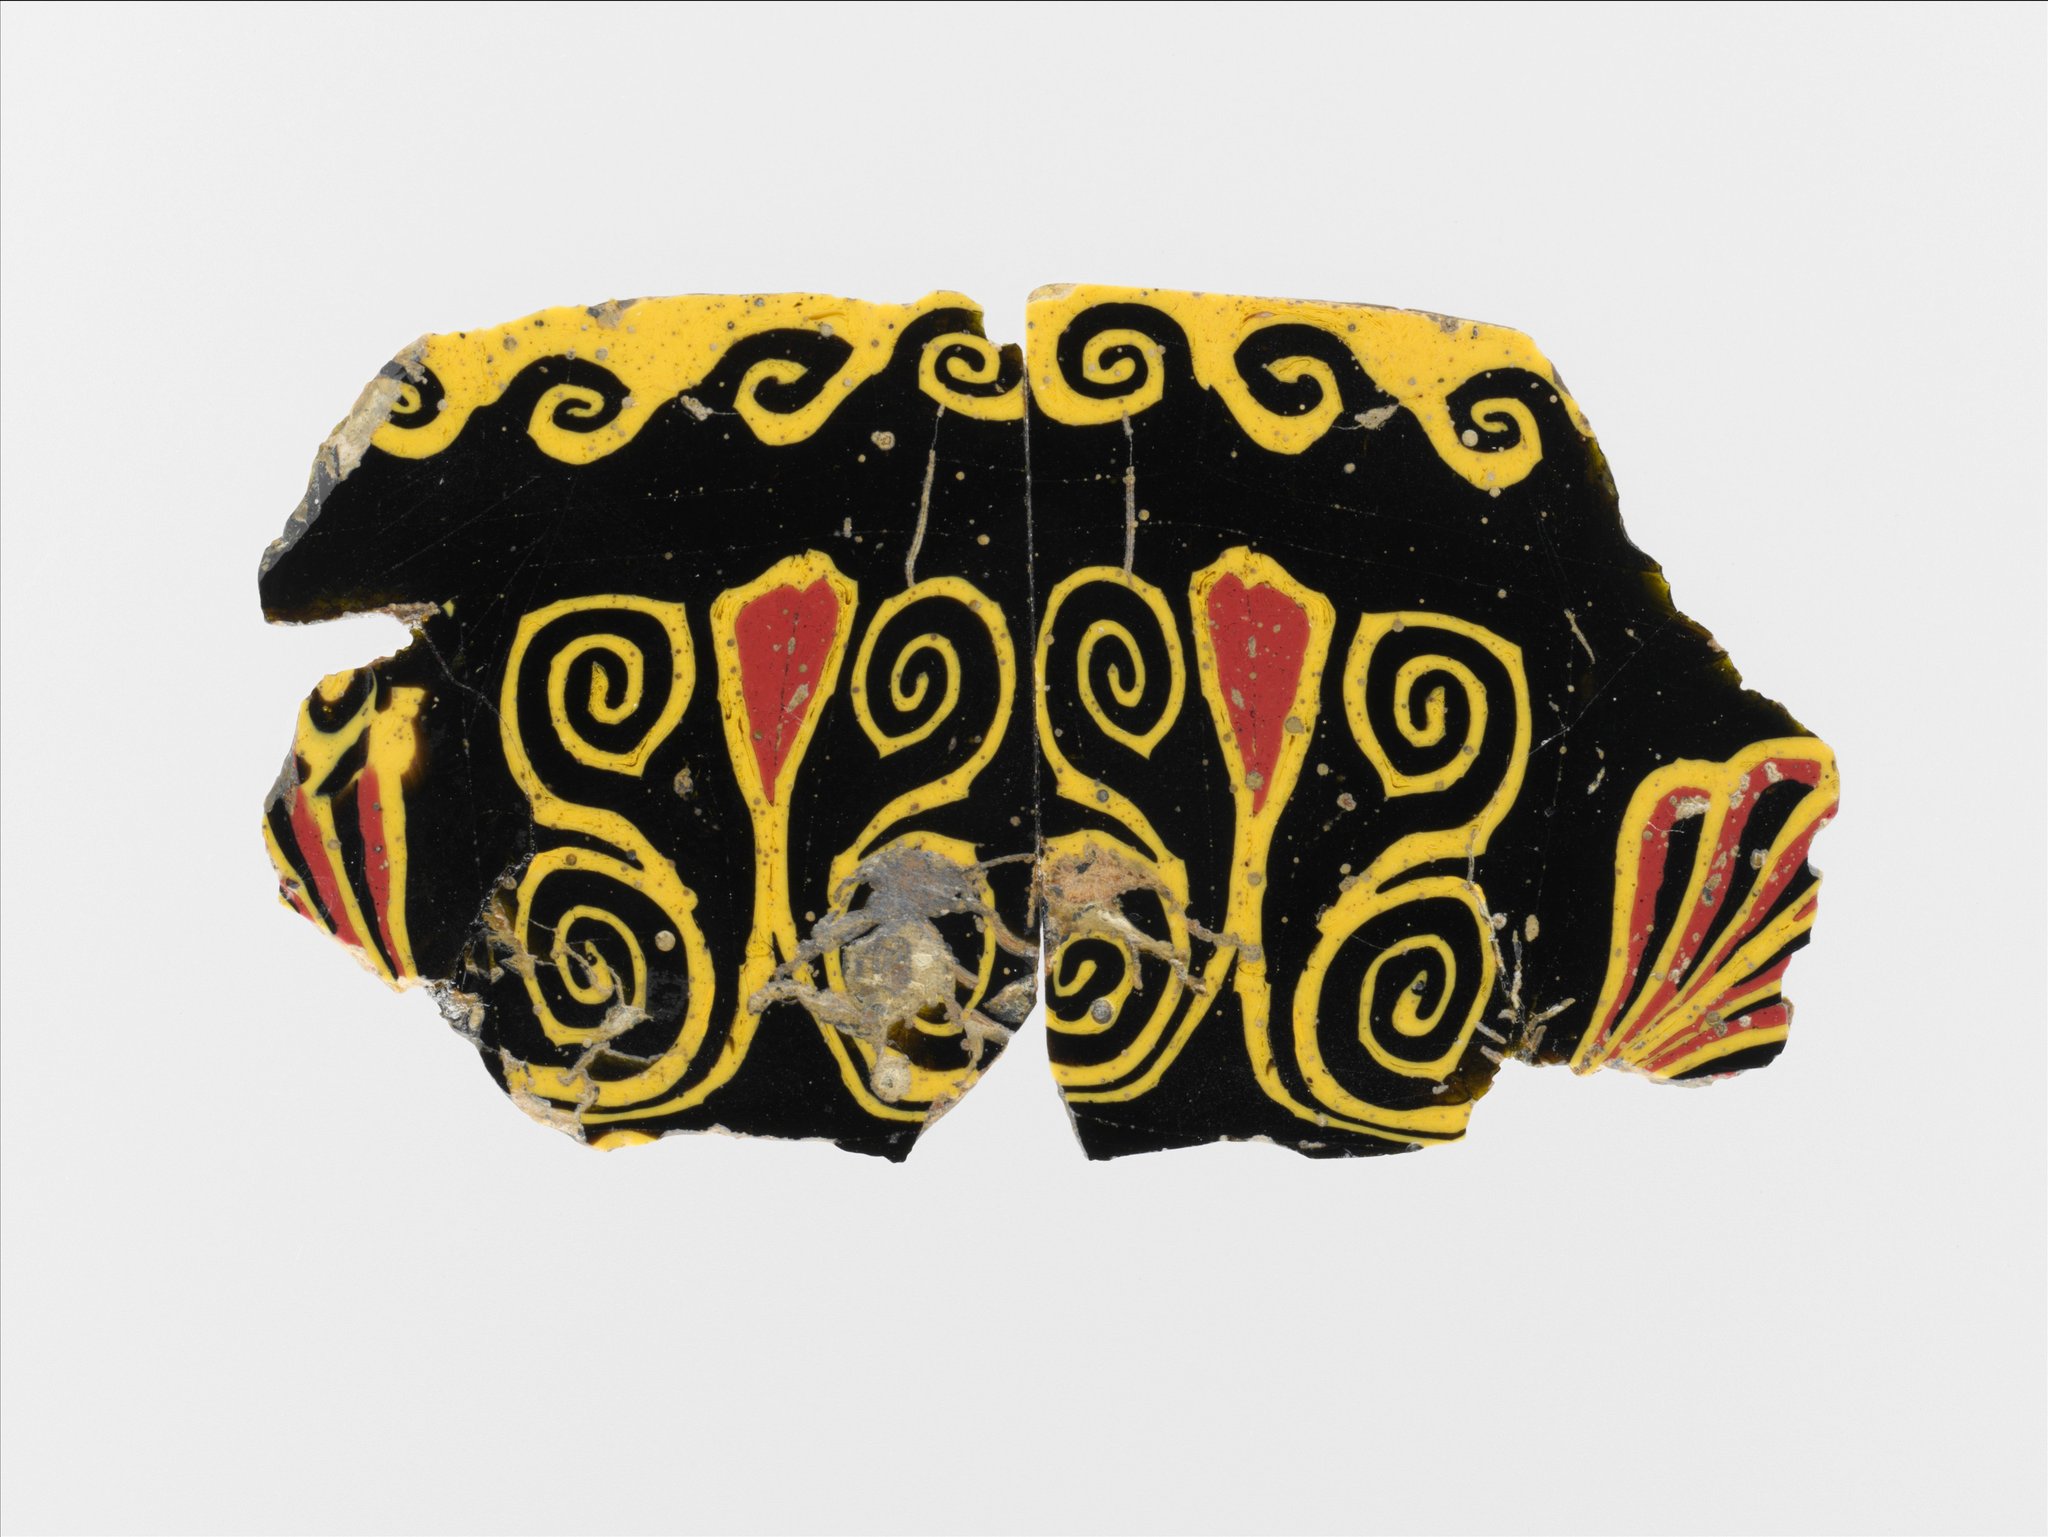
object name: mosaic block inlay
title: Glass mosaic inlay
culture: egyptian or roman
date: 100 BCE-100 CE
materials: glass